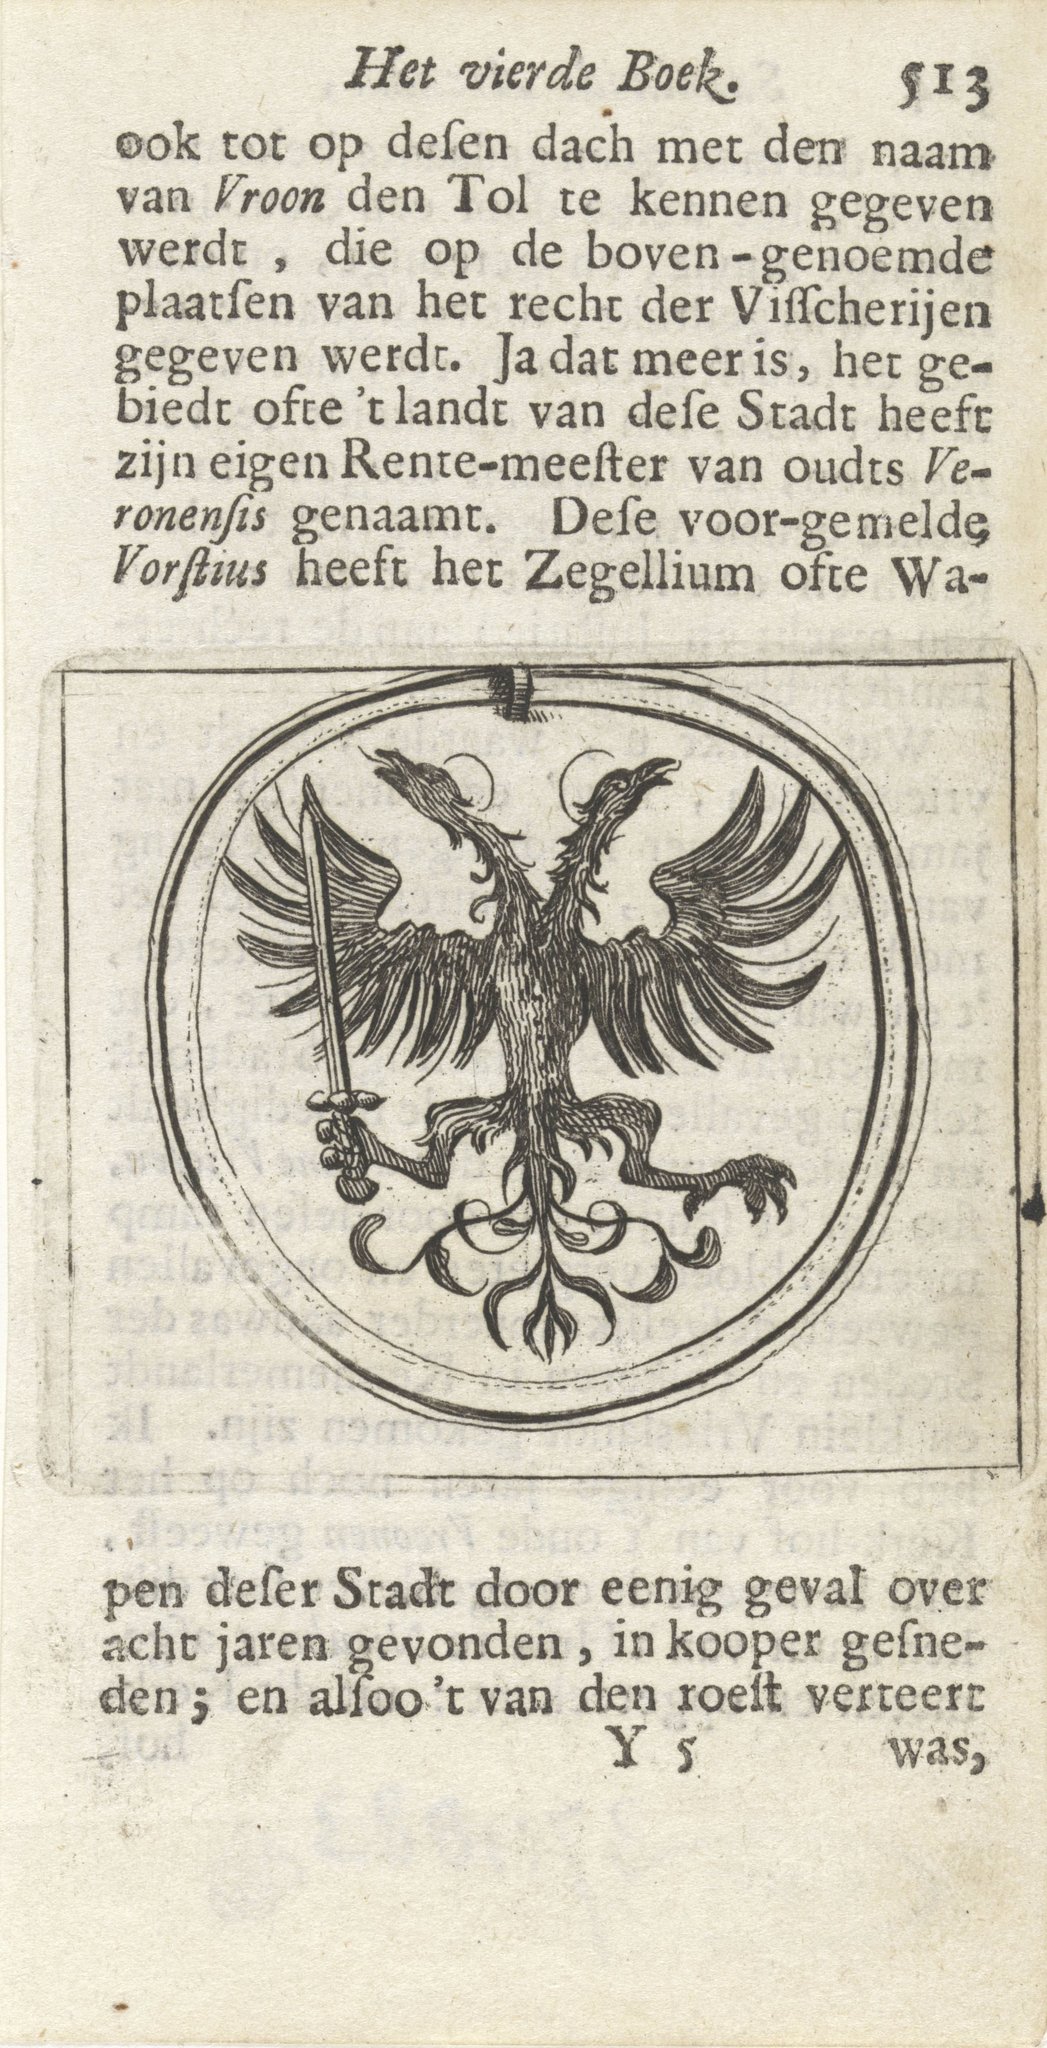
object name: print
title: Wapenschild van het dorp Vronen in West-Friesland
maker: hendrik jacobsz soeteboom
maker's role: print maker, publisher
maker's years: 1616-1678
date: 1658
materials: paper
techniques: engraving, etching, letterpress printing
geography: zaandam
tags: armorial bearing, heraldry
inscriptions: collector's mark: Lugt 2228, collector's mark: Lugt 2760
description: Wapenschild met een dubbelkoppige arend met zwaard. Dit wapen van het in 1297 verwoeste West-Friese dorp zou gevonden zijn door Nicolaas Vorstius. Boven en onder de prent tekst in boekdruk.